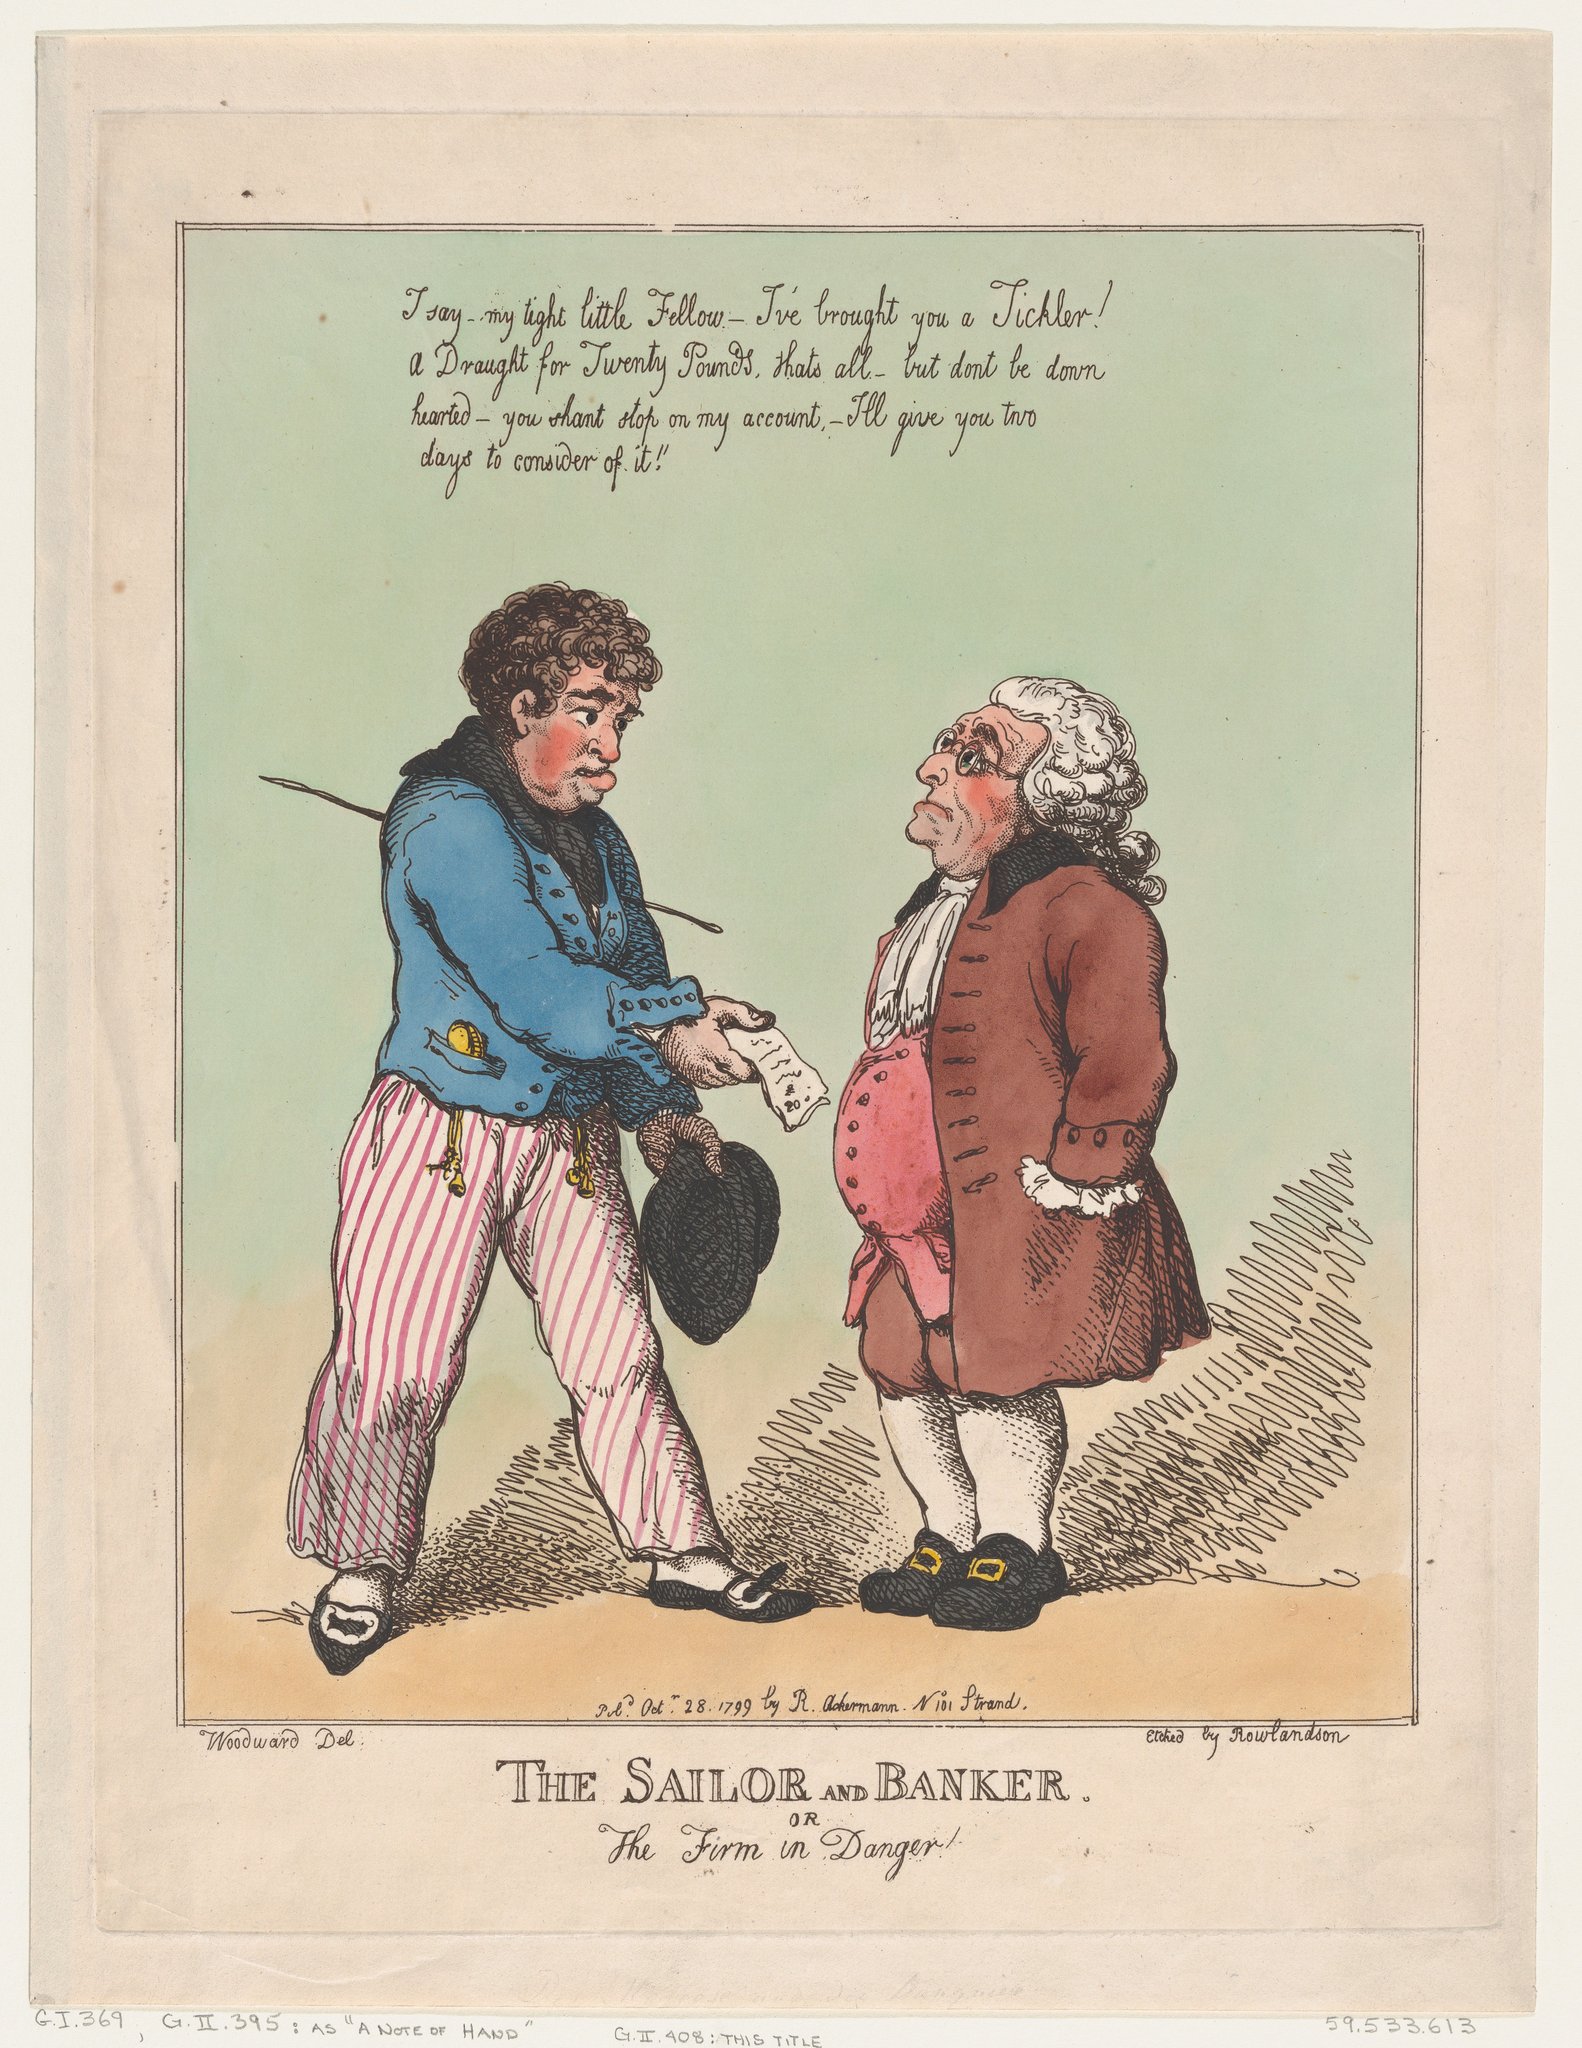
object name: print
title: The Sailor and Banker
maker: thomas rowlandson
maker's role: artist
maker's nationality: british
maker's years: 1757-1827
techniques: etching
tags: satire,men,sailors